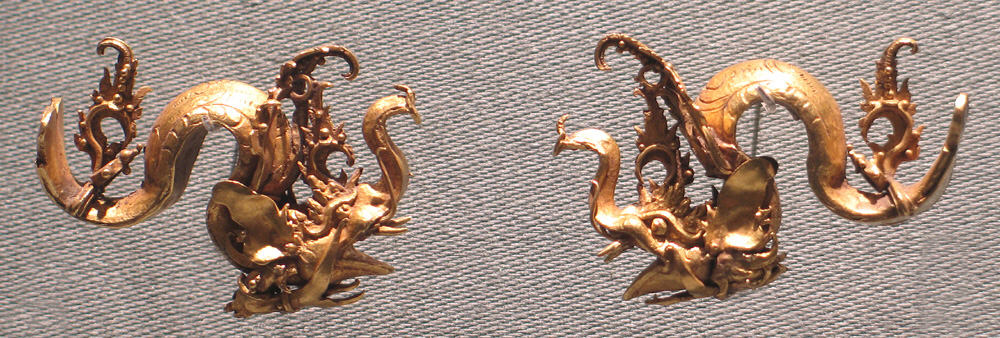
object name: ear ornament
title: Pair of Ear Ornaments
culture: indonesian, javanese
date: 801-1400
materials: gold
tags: dragons